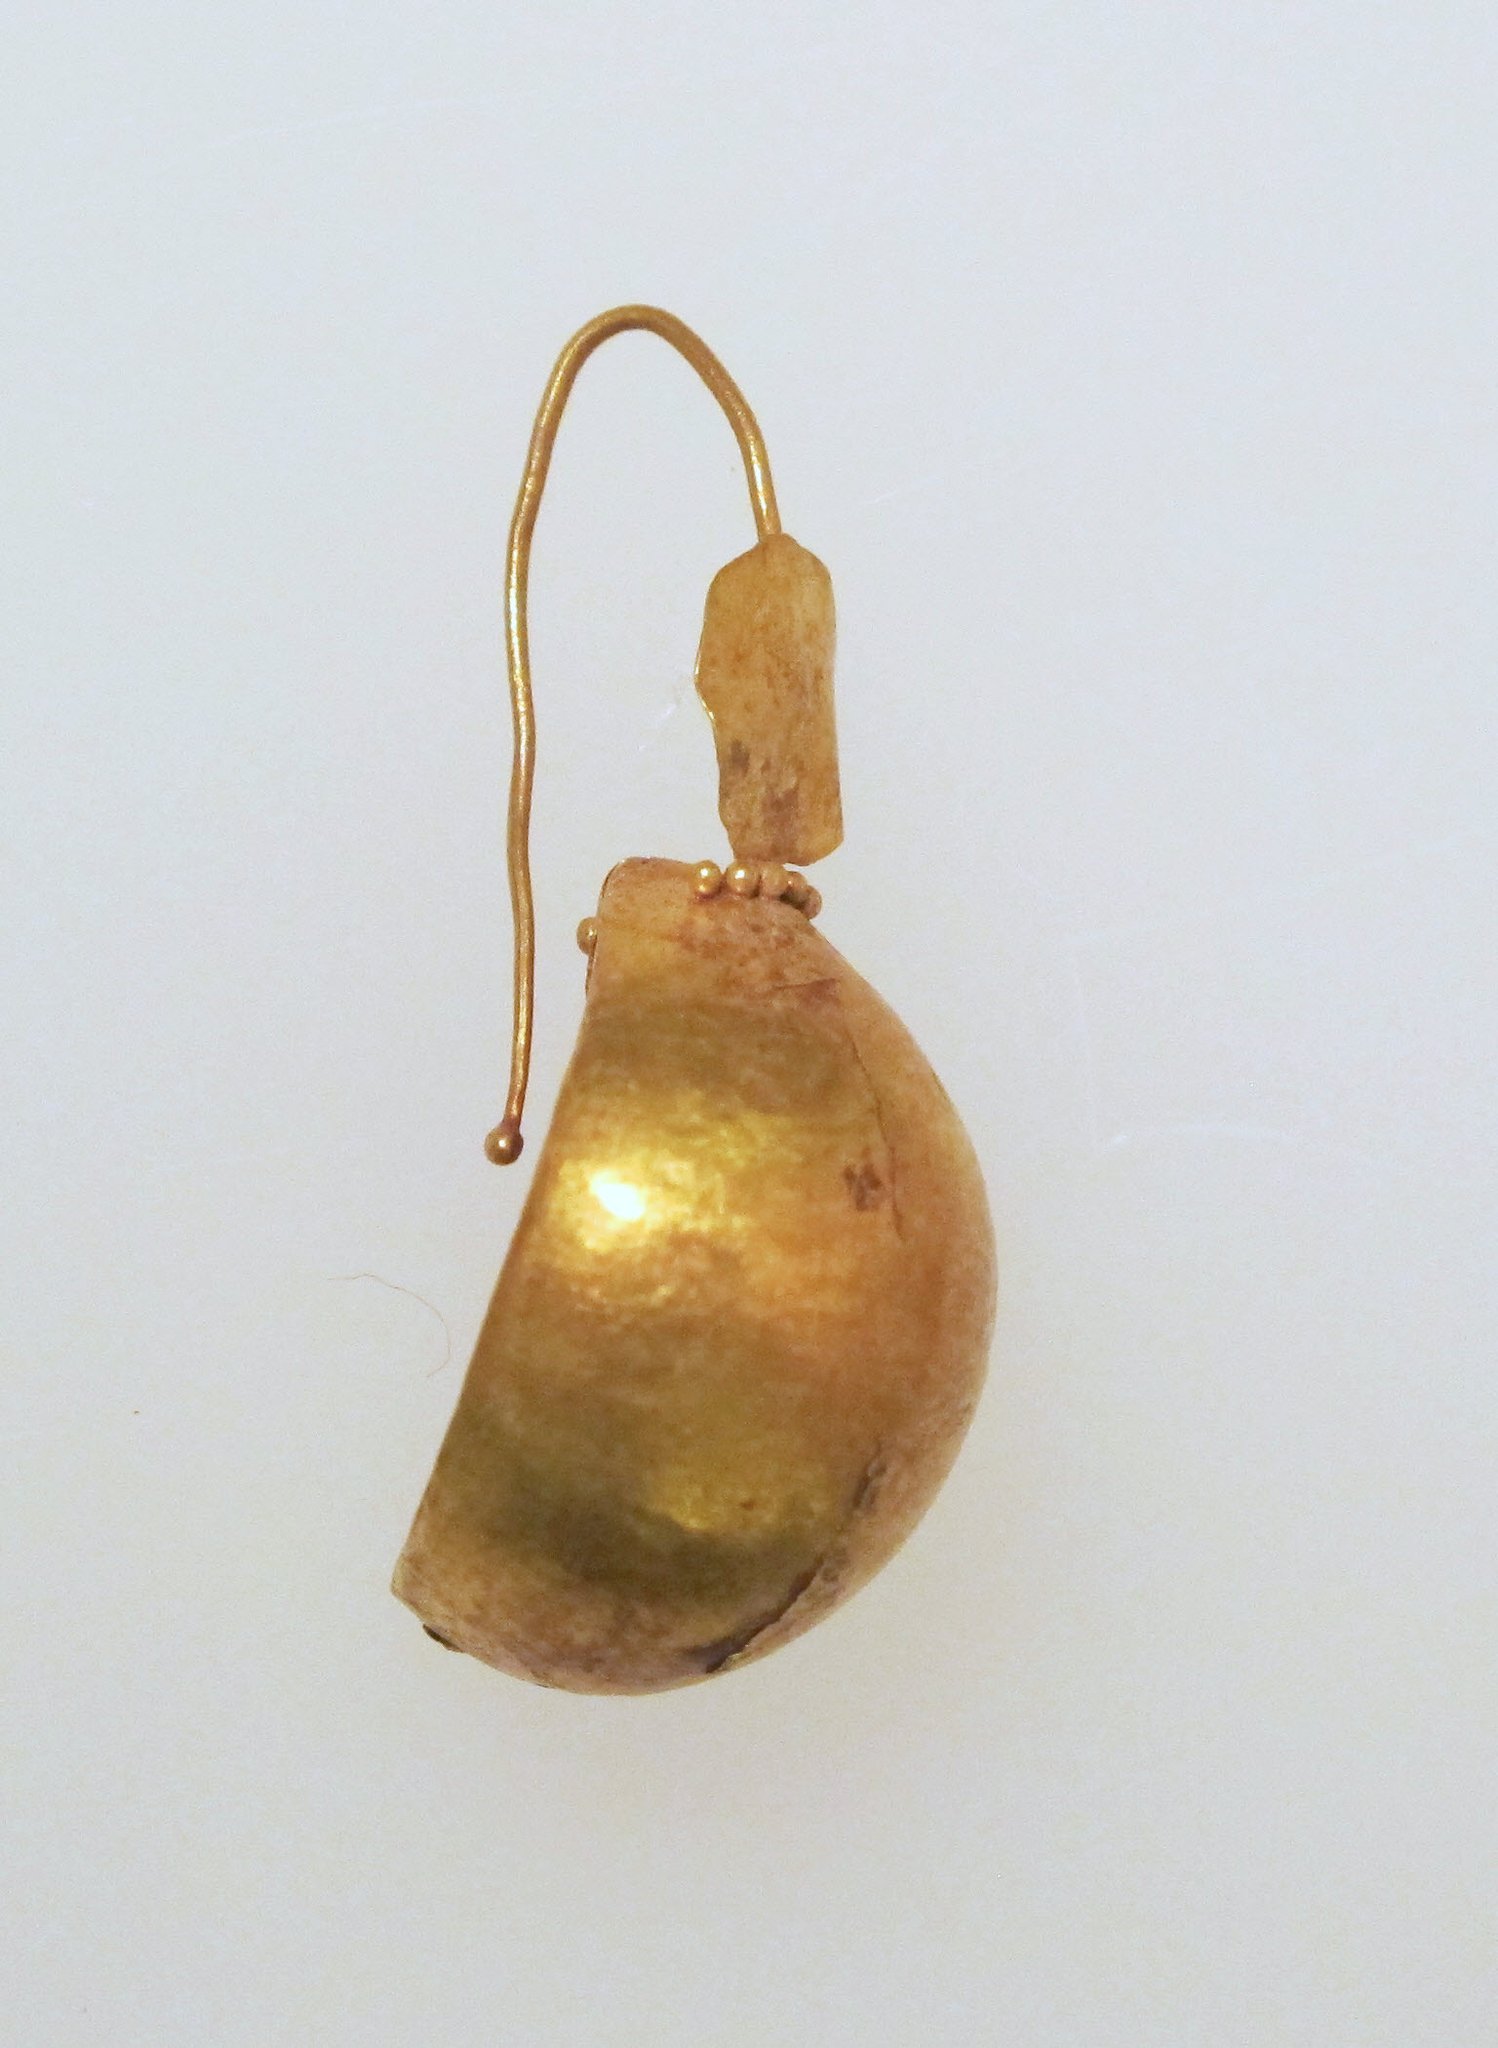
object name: earring hook type with disc of thin foil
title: Earring-hook type with discs of thin foil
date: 7000 BCE-330 CE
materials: gold